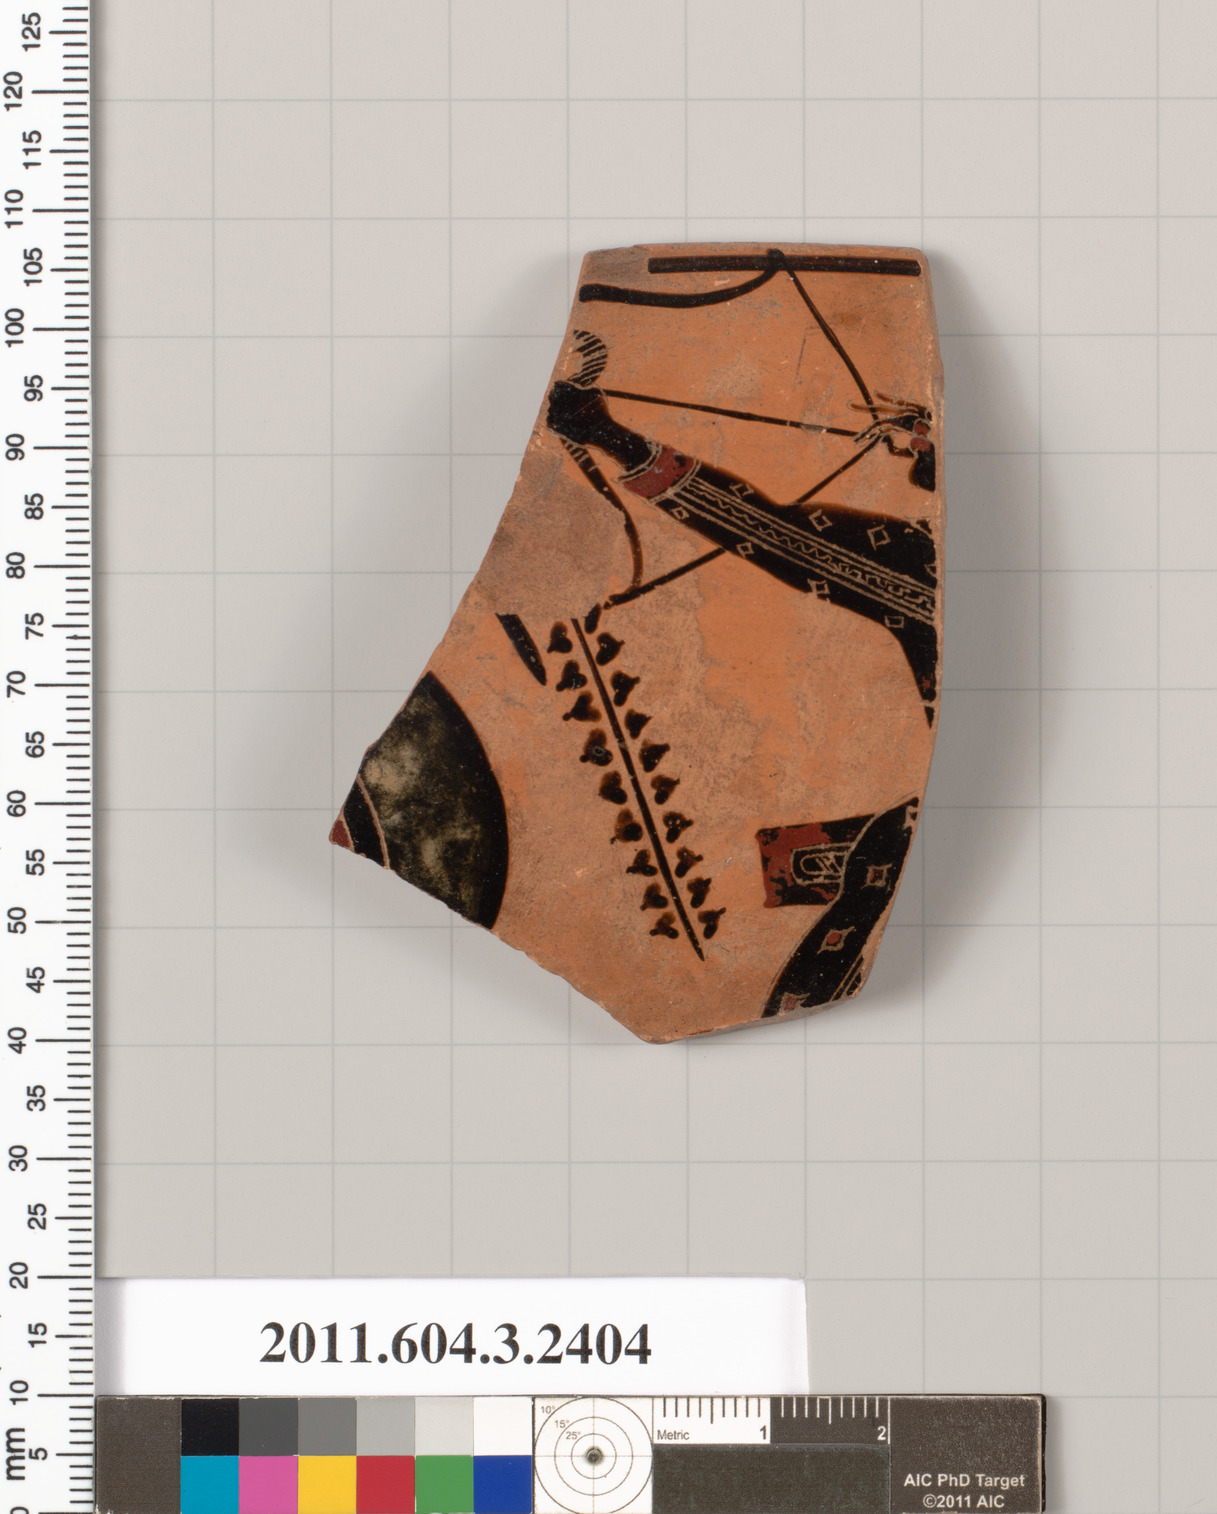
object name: kylix fragment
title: Terracotta rim fragment of a kylix: eye-cup (drinking cup)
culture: greek, attic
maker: psiax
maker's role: artist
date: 530-500 BCE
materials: terracotta